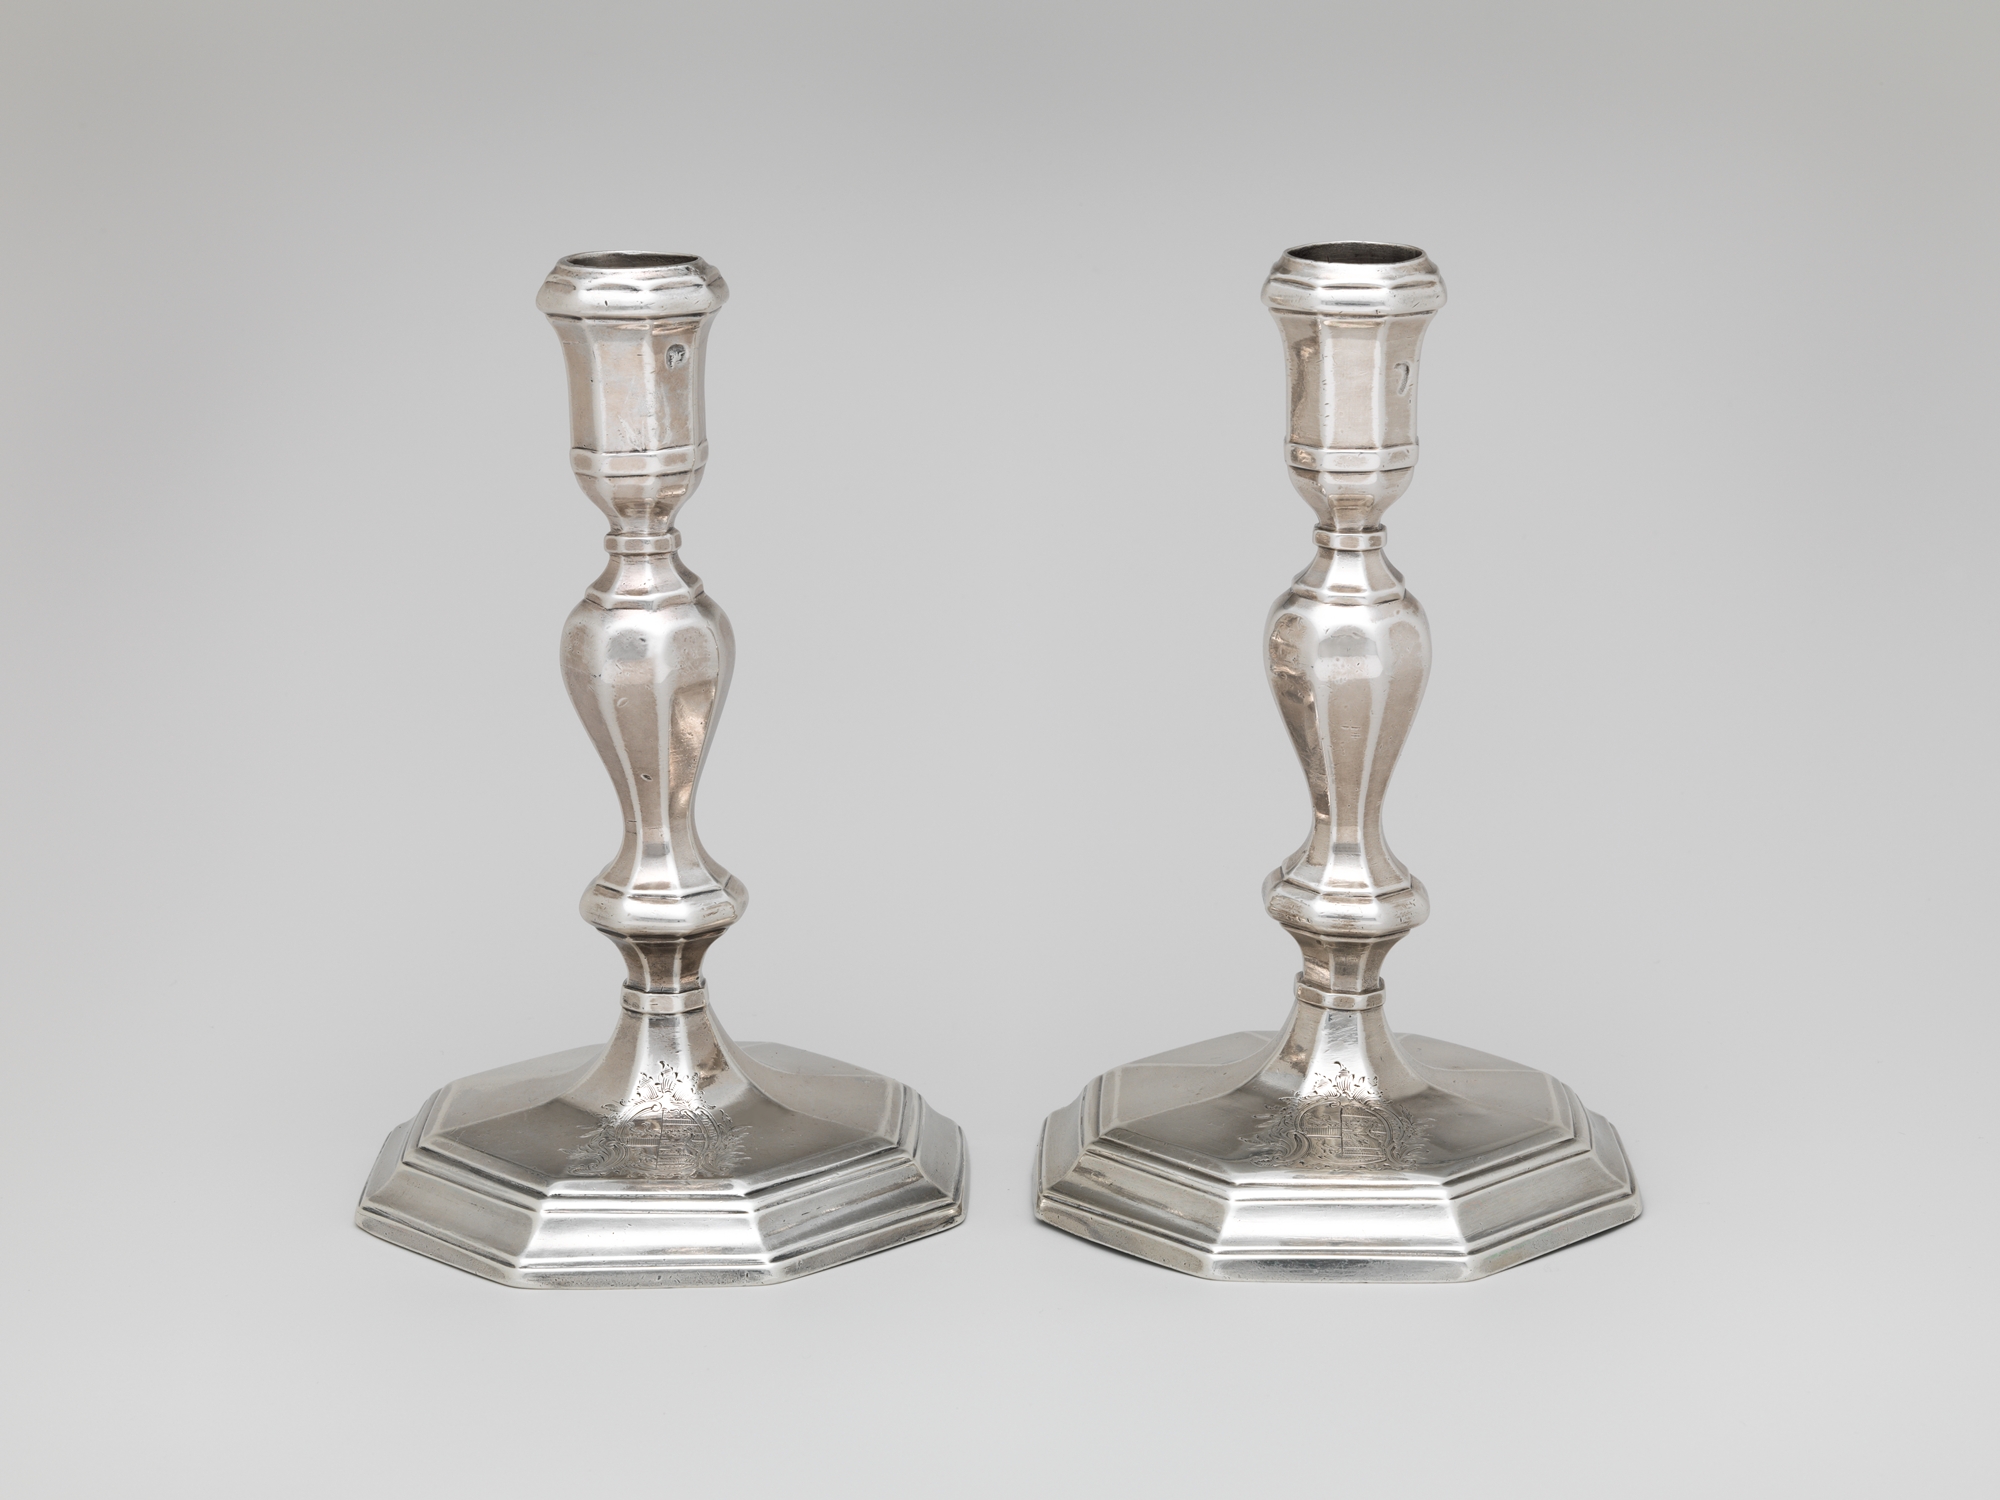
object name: candlestick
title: Pair of candlesticks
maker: thomas merry i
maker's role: maker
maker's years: 1701-1724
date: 1706-1707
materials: silver